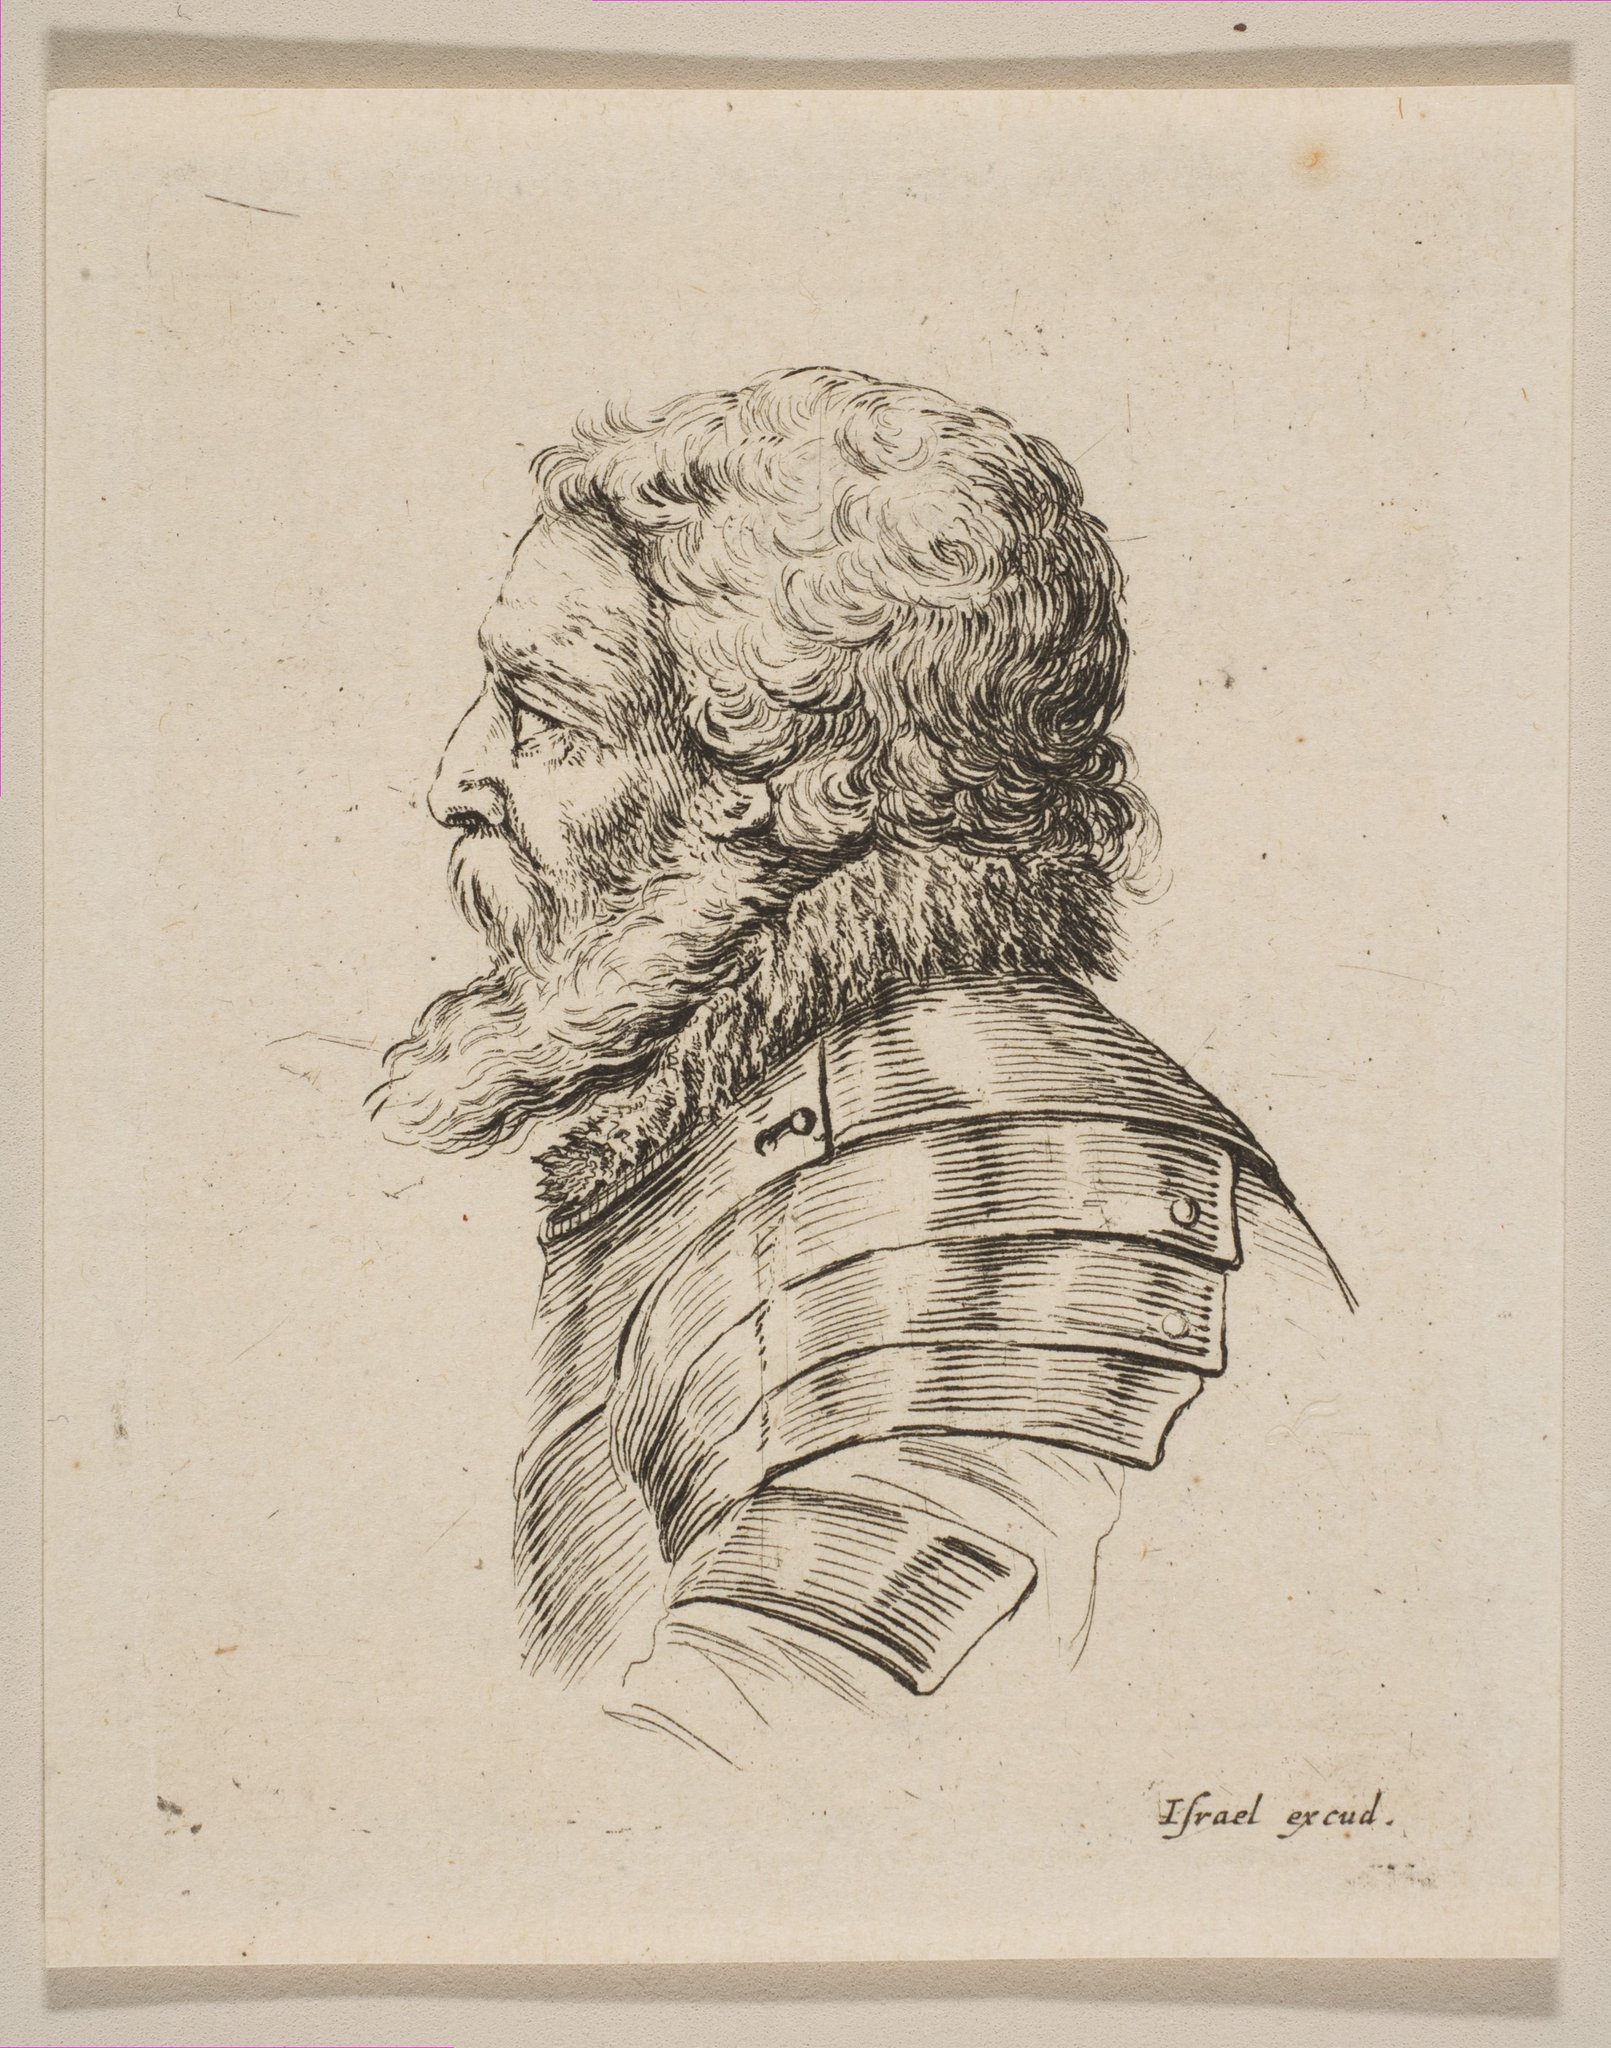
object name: print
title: Bust of a Soldier in Profile, from 'Various heads and figures' (Diverses tétes et figures)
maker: stefano della bella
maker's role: artist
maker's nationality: italian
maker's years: 1610-1664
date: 1650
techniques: etching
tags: soldiers,men,profiles